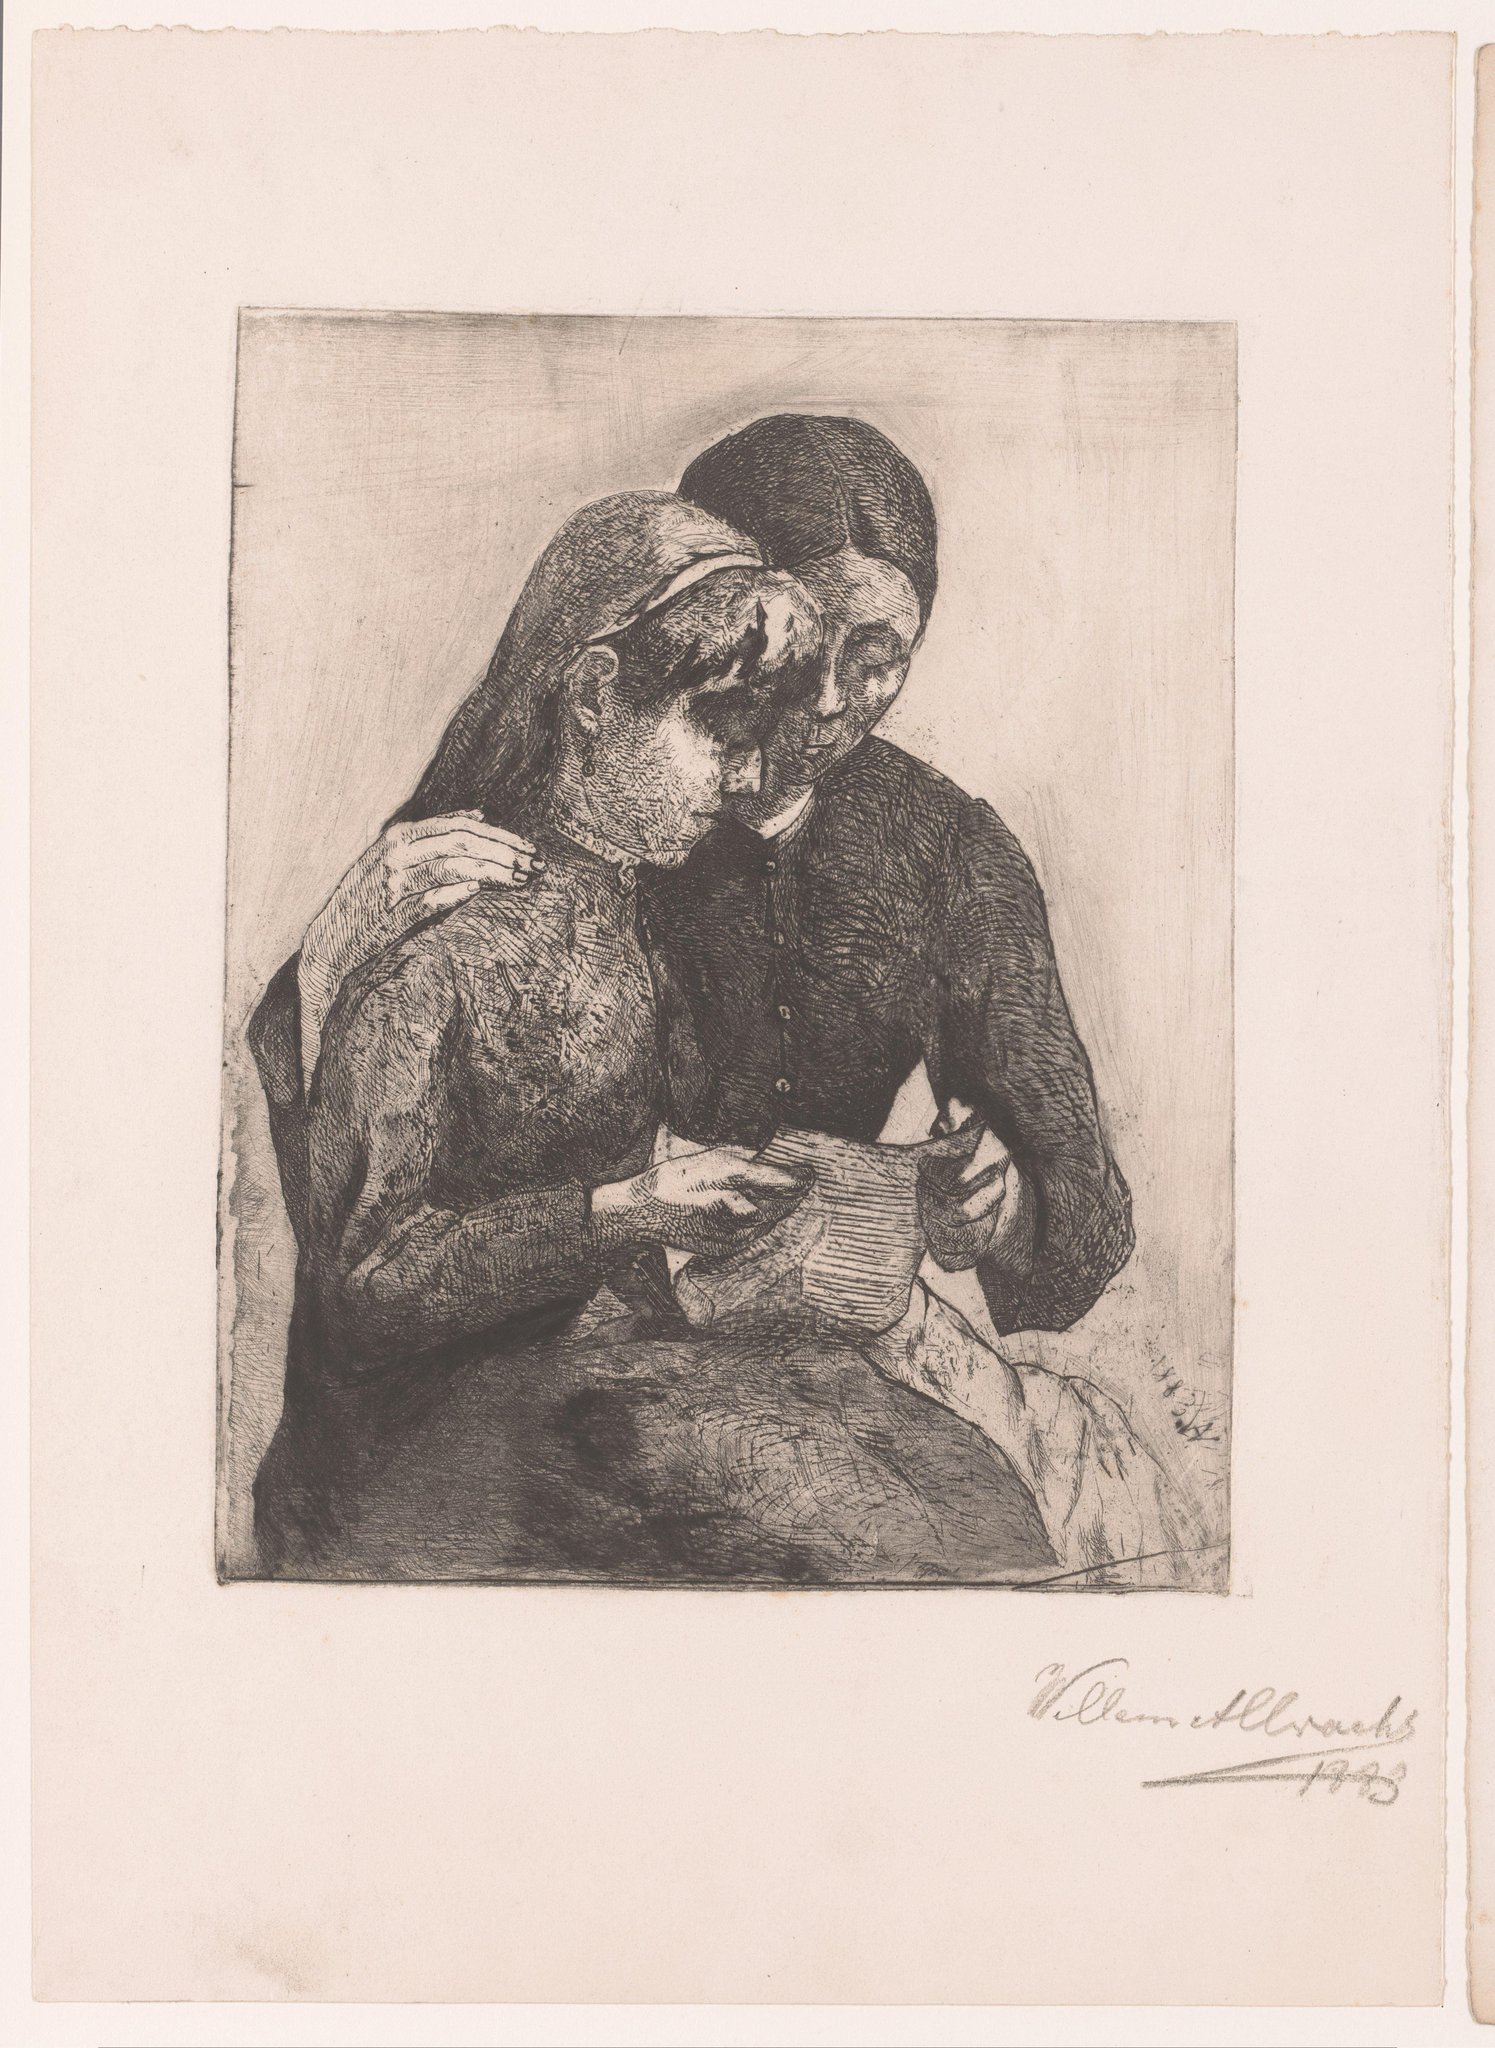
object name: print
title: Twee zittende vrouwen lezen samen een brief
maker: willem albracht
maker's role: print maker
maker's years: 1861-1922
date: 1883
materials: paper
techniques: drypoint, etching, intaglio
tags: reading, the ages of man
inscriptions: collector's mark: Lugt 2228